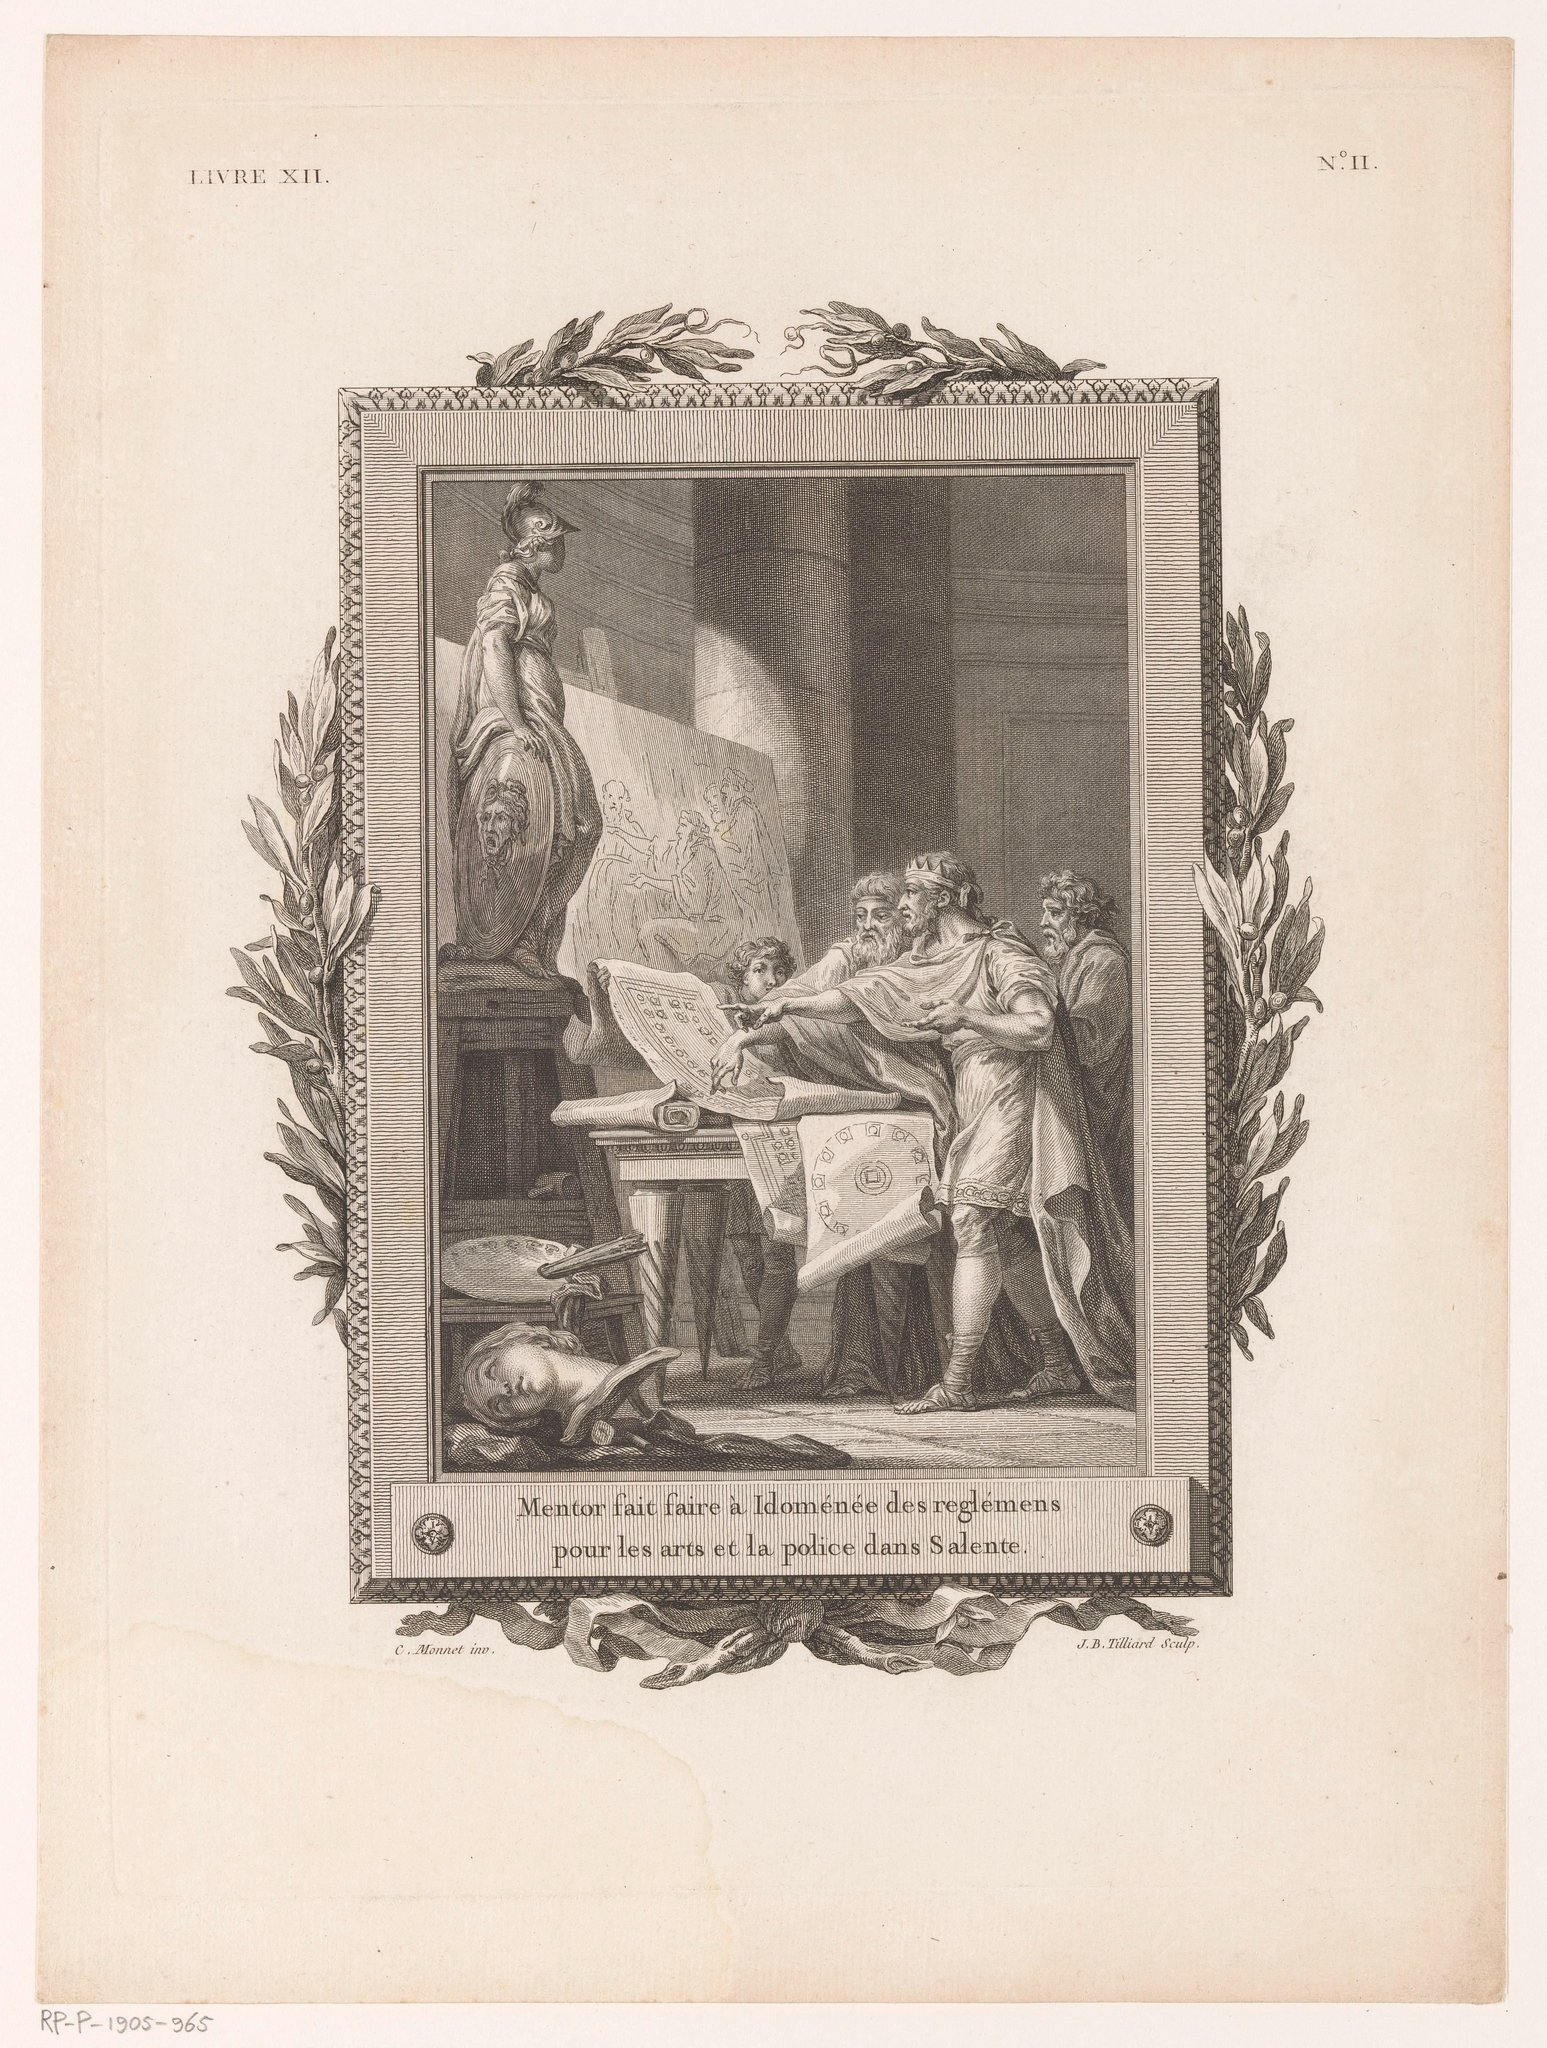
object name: book illustration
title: Mentor toont Idomeneus regelgeving voor de kunsten en de politie te Salento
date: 1785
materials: paper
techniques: engraving, etching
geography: paris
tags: (fenelon, telemachus) specific works of literature (with author, title), (story of) telemachus, ornament ~ festoon, garland, telemachus starts out with mentor, in search of his father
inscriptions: collector's mark: Lugt 2228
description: Idomeneus en Mentor, staand voor een tafel en schildersezel met schilderij, kijken naar plattegronden. Het geheel wordt gekaderd door een sierlijst met olijftakken en onderaan een strik. Genummerd rechtsboven: No. II.